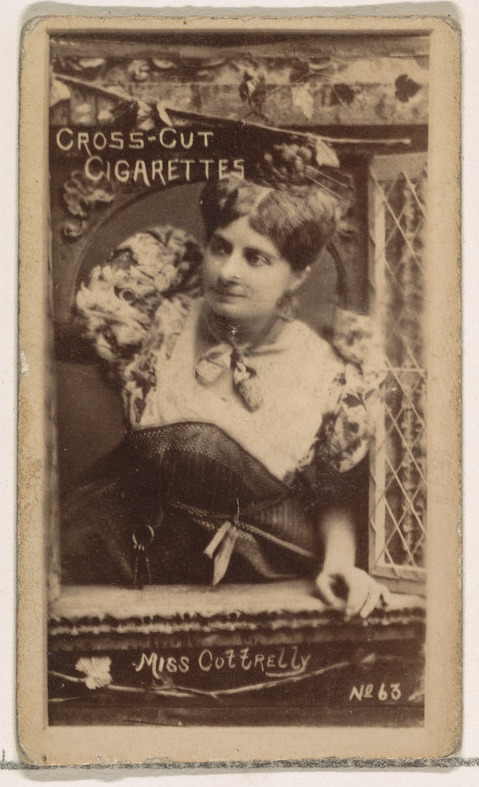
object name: print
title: Card Number 63, Miss Cottrelly, from the Actors and Actresses series (N145-1) issued by Duke Sons & Co. to promote Cross Cut Cigarettes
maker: w. duke, sons & co.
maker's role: publisher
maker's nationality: american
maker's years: 1870-1920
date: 1880-1889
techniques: albumen silver print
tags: portraits,women,actresses